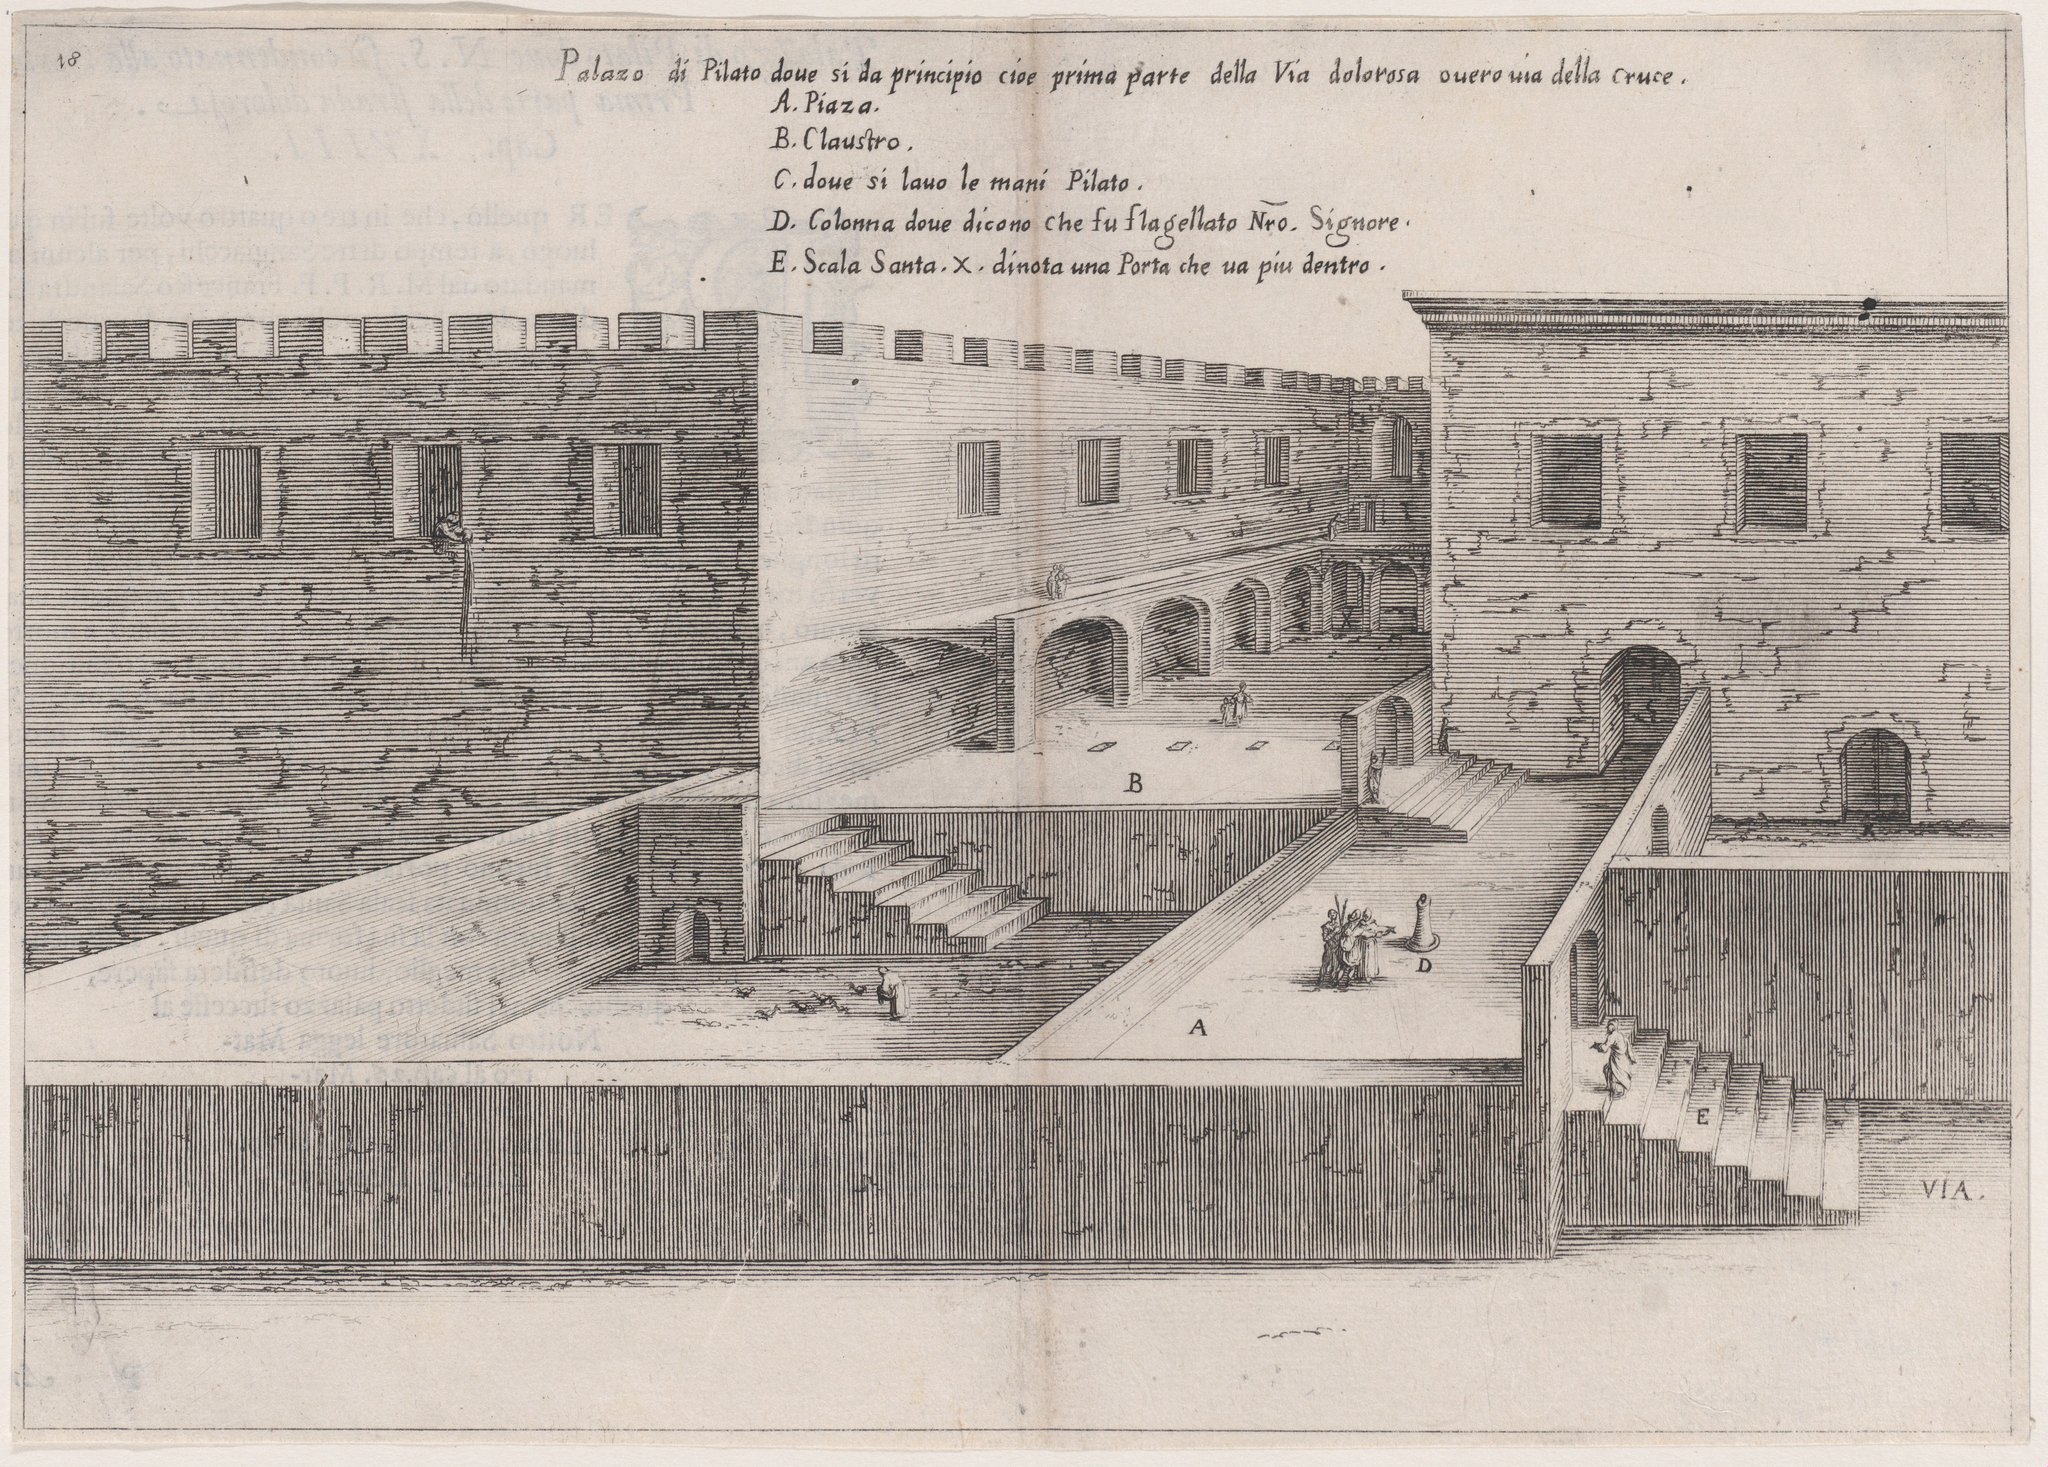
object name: print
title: Plate 14, from "Trattato delle Piante & Immagini de Sacri Edifizi di Terra Santa" (Treatise of the Plans & Images of the Sacred Buildings of the Holy Land)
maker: jacques callot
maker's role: artist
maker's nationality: french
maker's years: 1592-1635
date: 1620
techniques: engraving, etching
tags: architecture,buildings